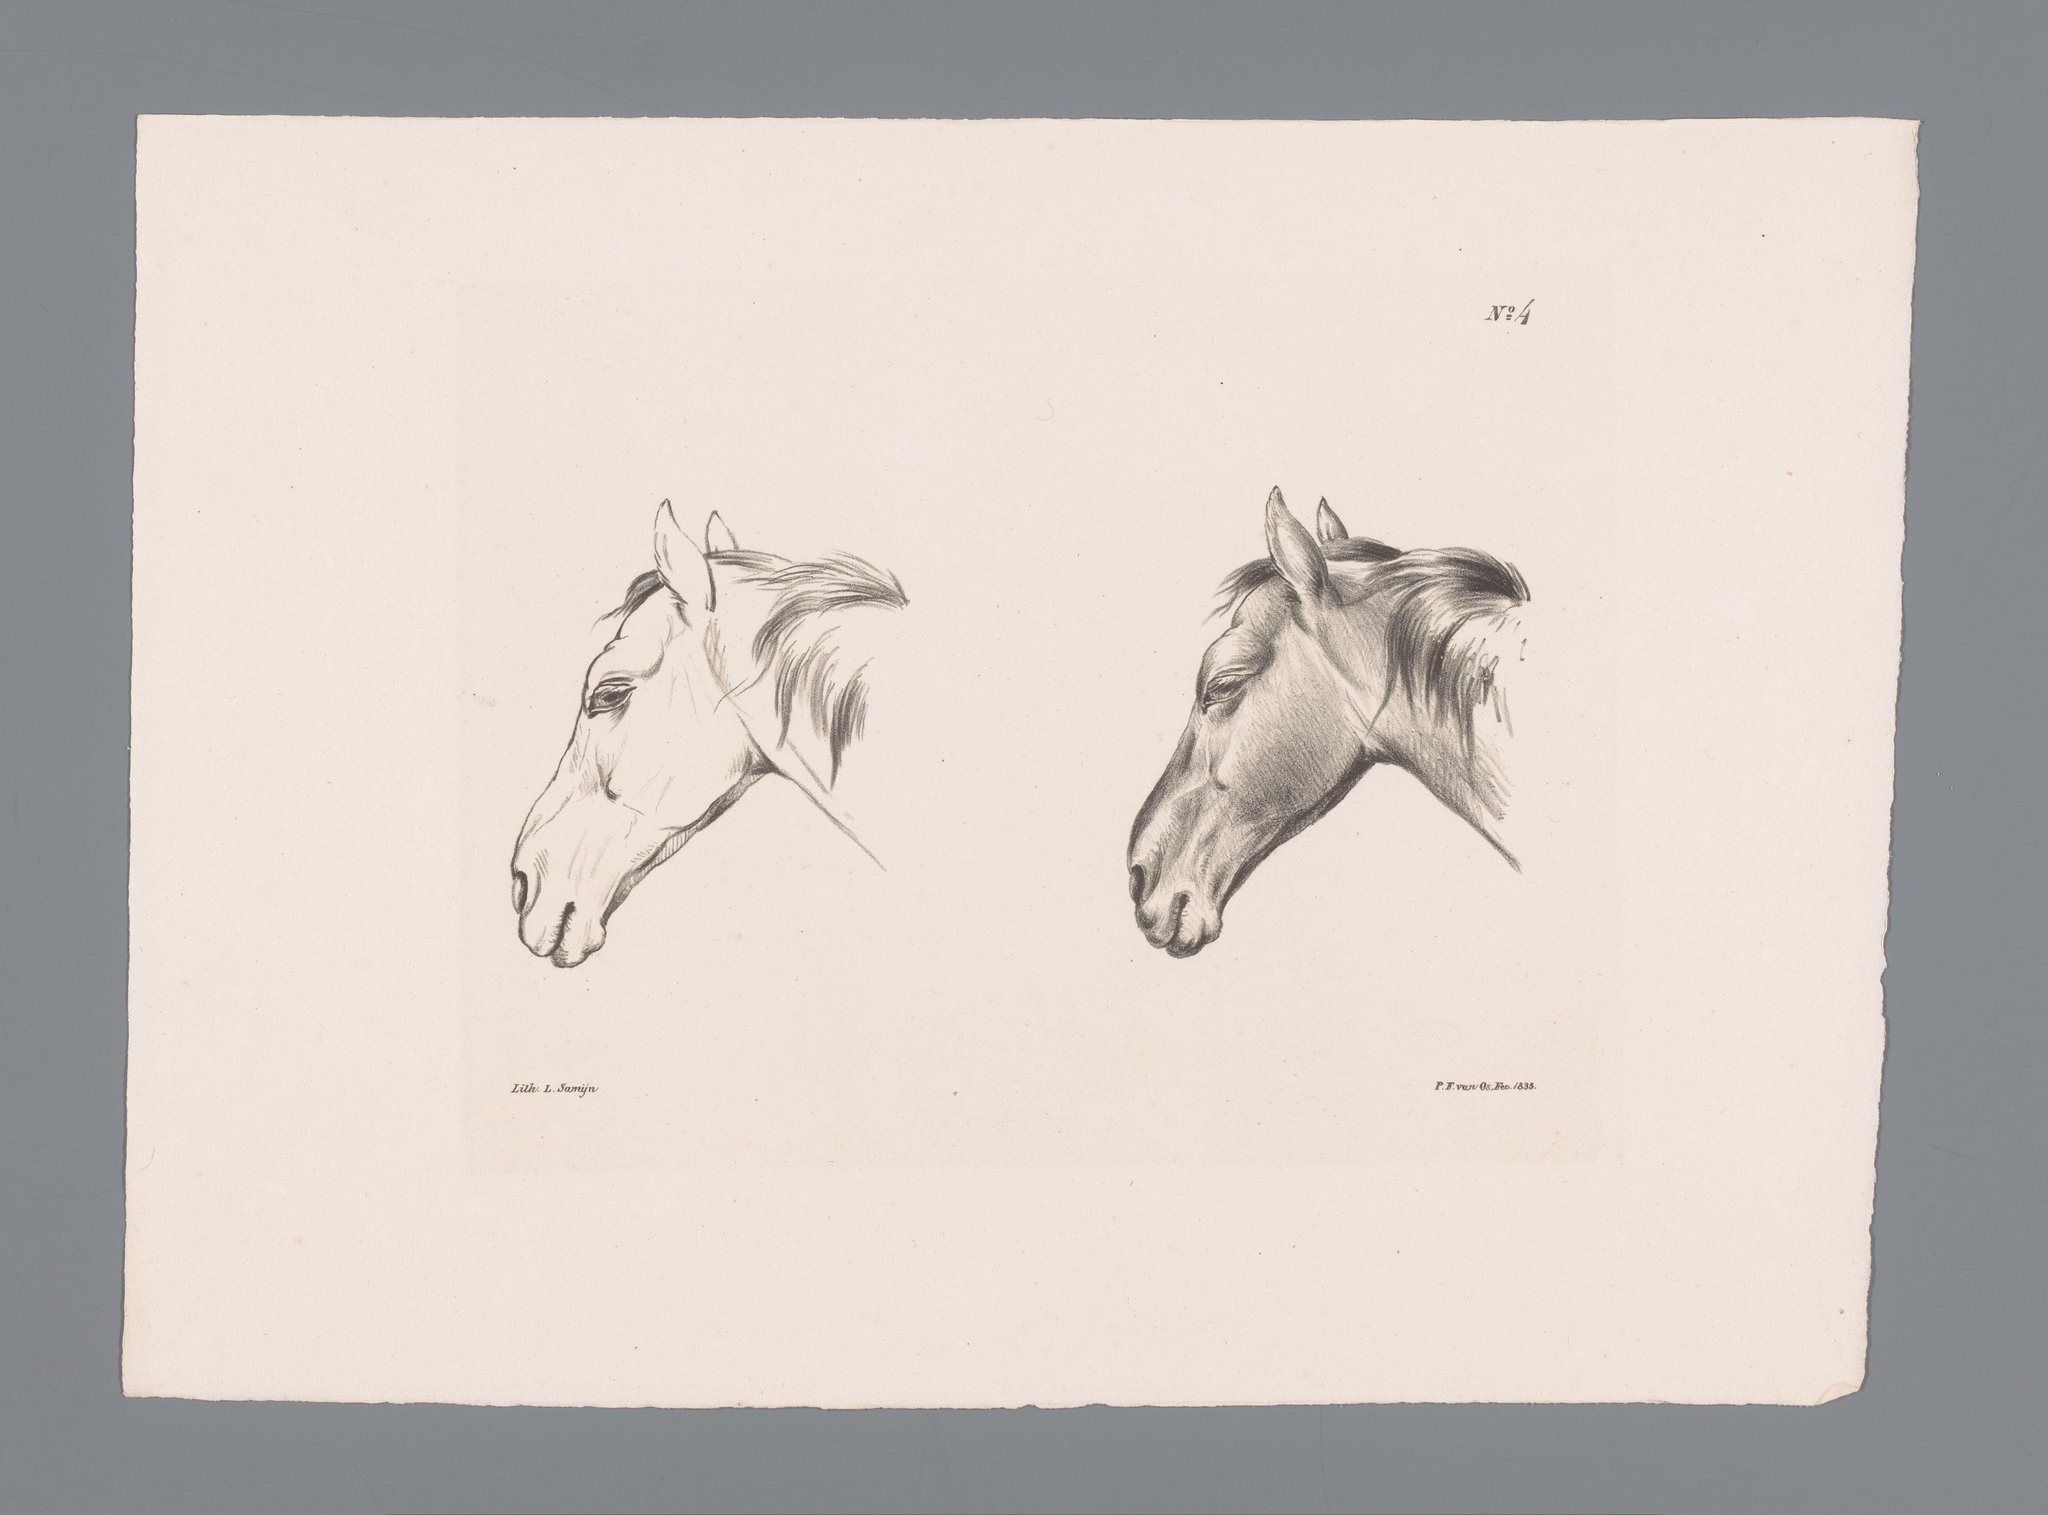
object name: print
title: Paarden Studien naar 't leven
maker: l. samijn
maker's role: printer, publisher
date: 1835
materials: paper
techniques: lithograph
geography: amsterdam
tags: animals (+ head of an animal), horse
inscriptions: collector's mark: Lugt 2228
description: Onderdeel van een omslag met een serie van tien paardenstudies.